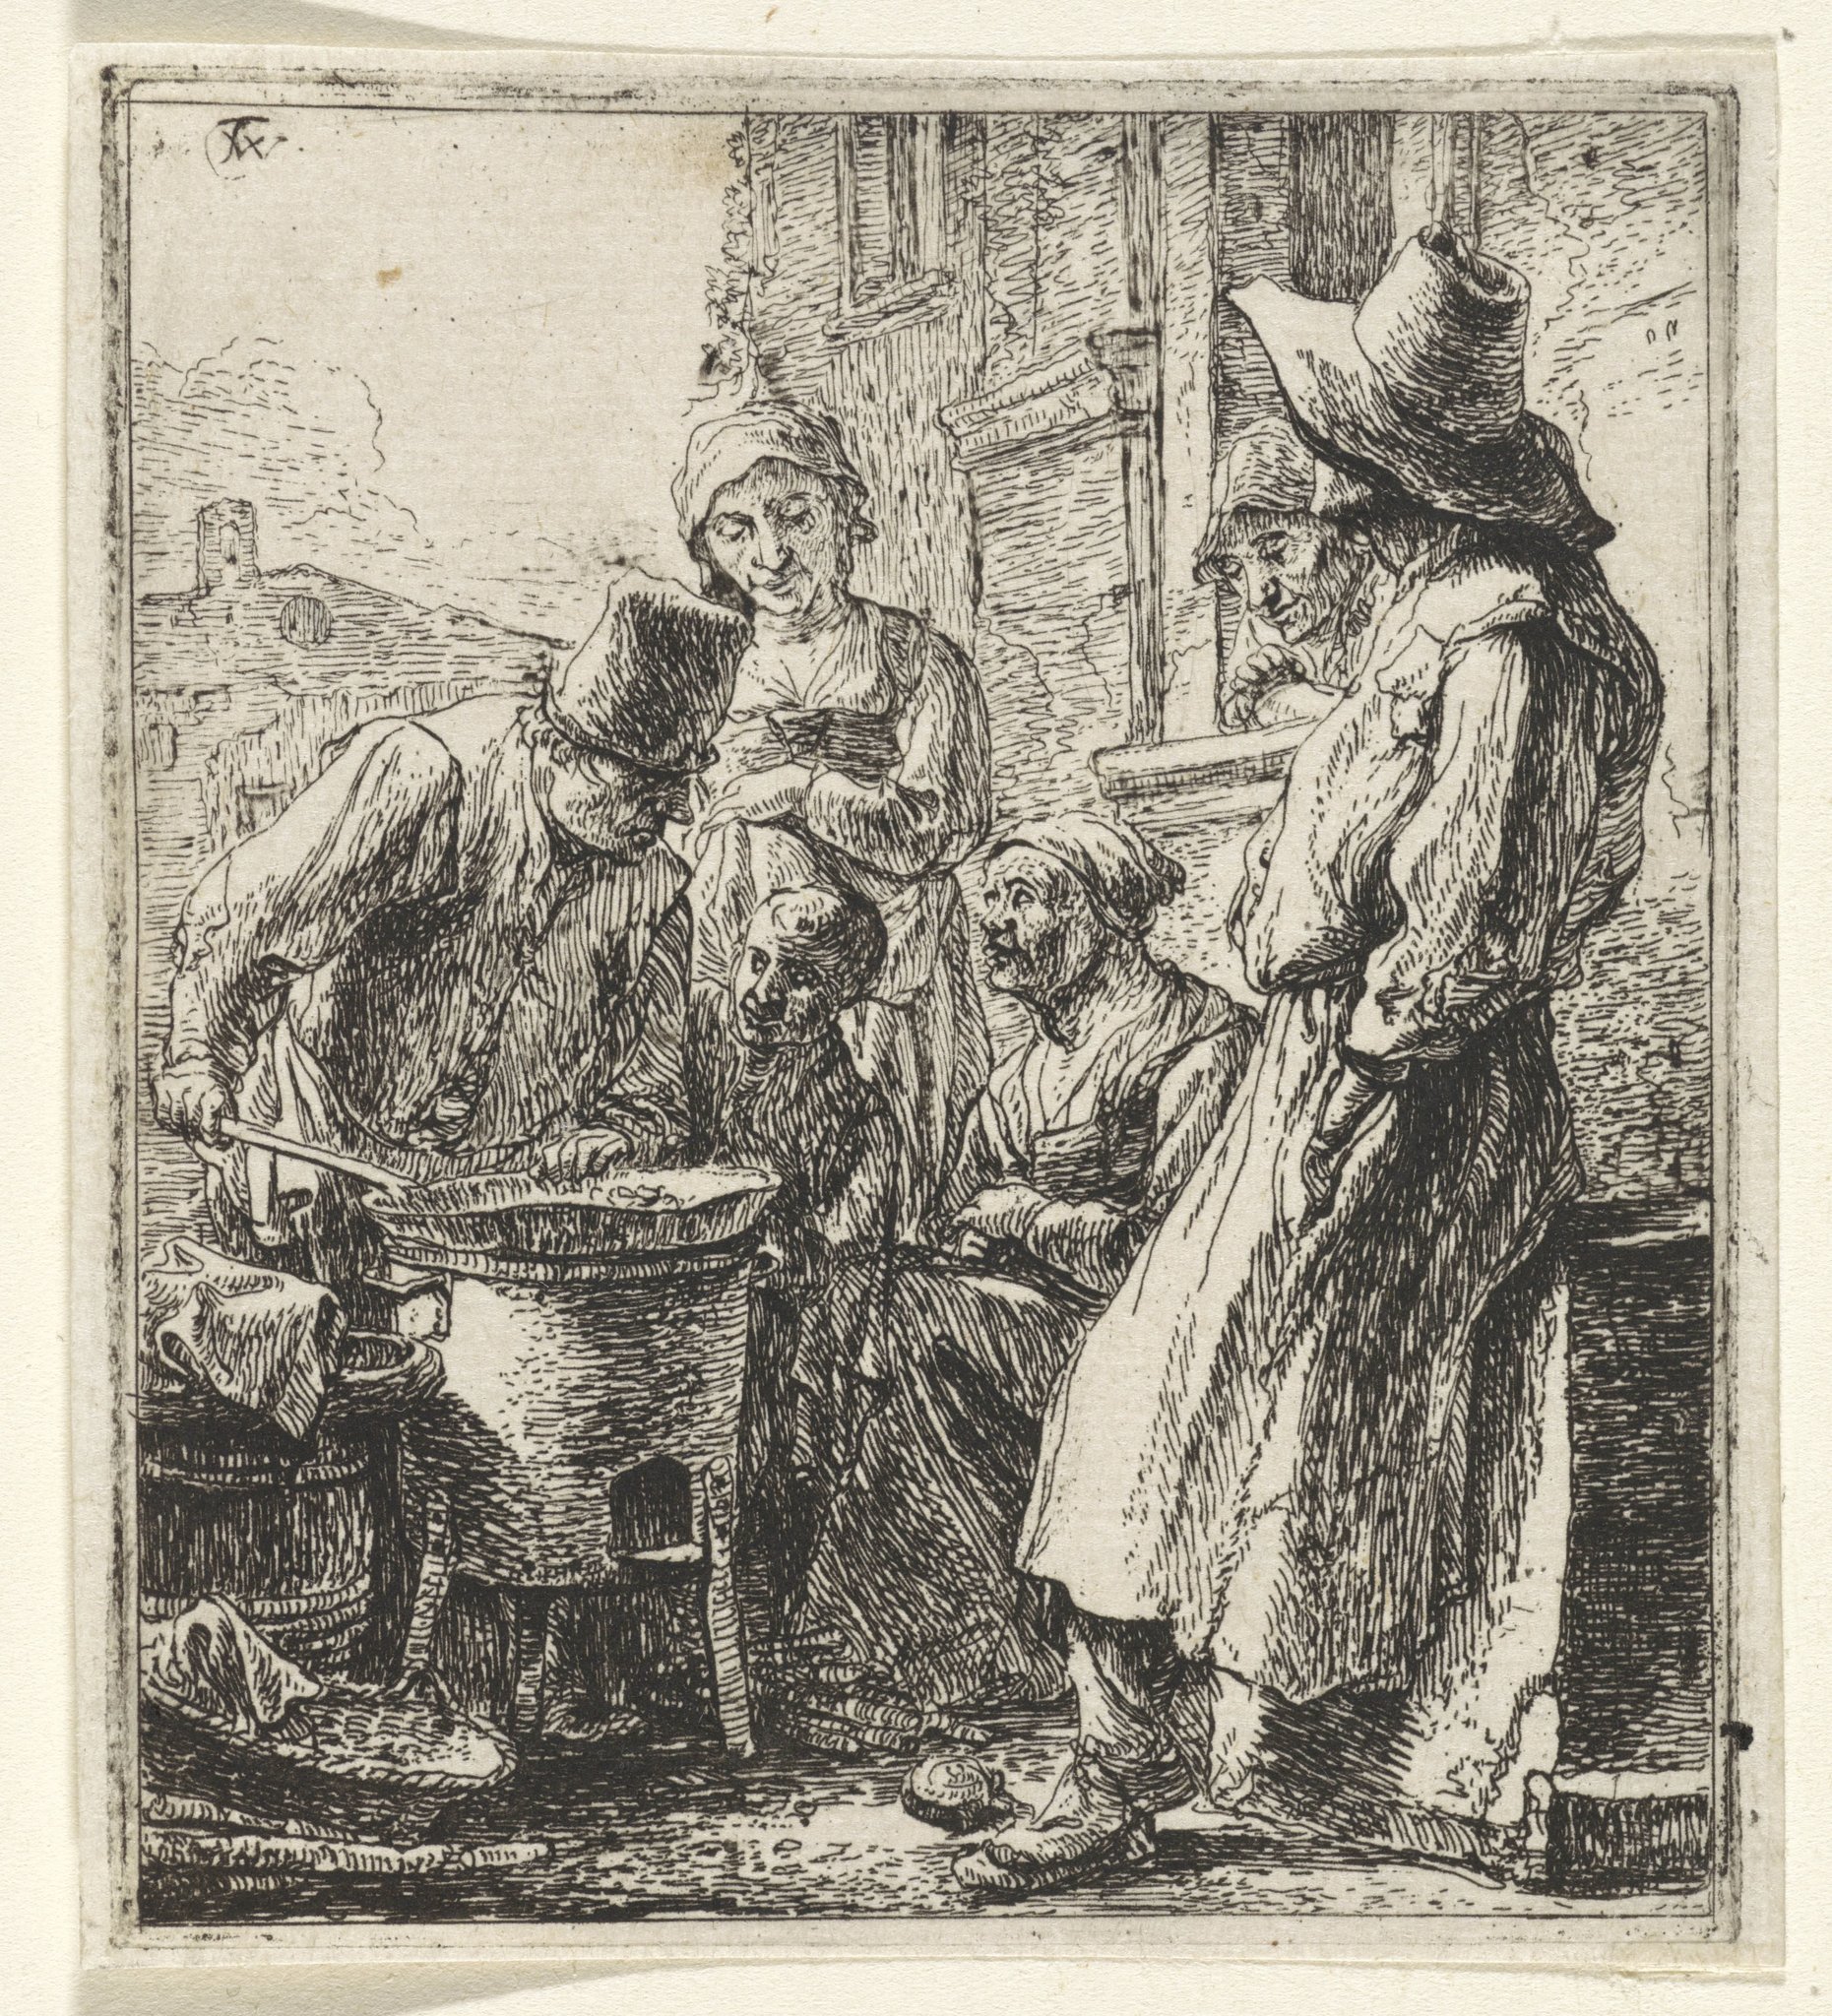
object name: print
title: De kastanjeverkoper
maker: thomas wijck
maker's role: draughtsman, painter, print maker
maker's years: 1616-1677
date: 1626-1677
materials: paper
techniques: etching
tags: fruits: chestnut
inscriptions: collector's mark: Lugt 2228, collector's mark: ‘F. Rechberger 1803’ Lugt 2133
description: Een man roostert kastanjes. Om hen heen twee mannen en twee vrouwen. Een andere vrouw kijkt vanuit het venster van haar huis.